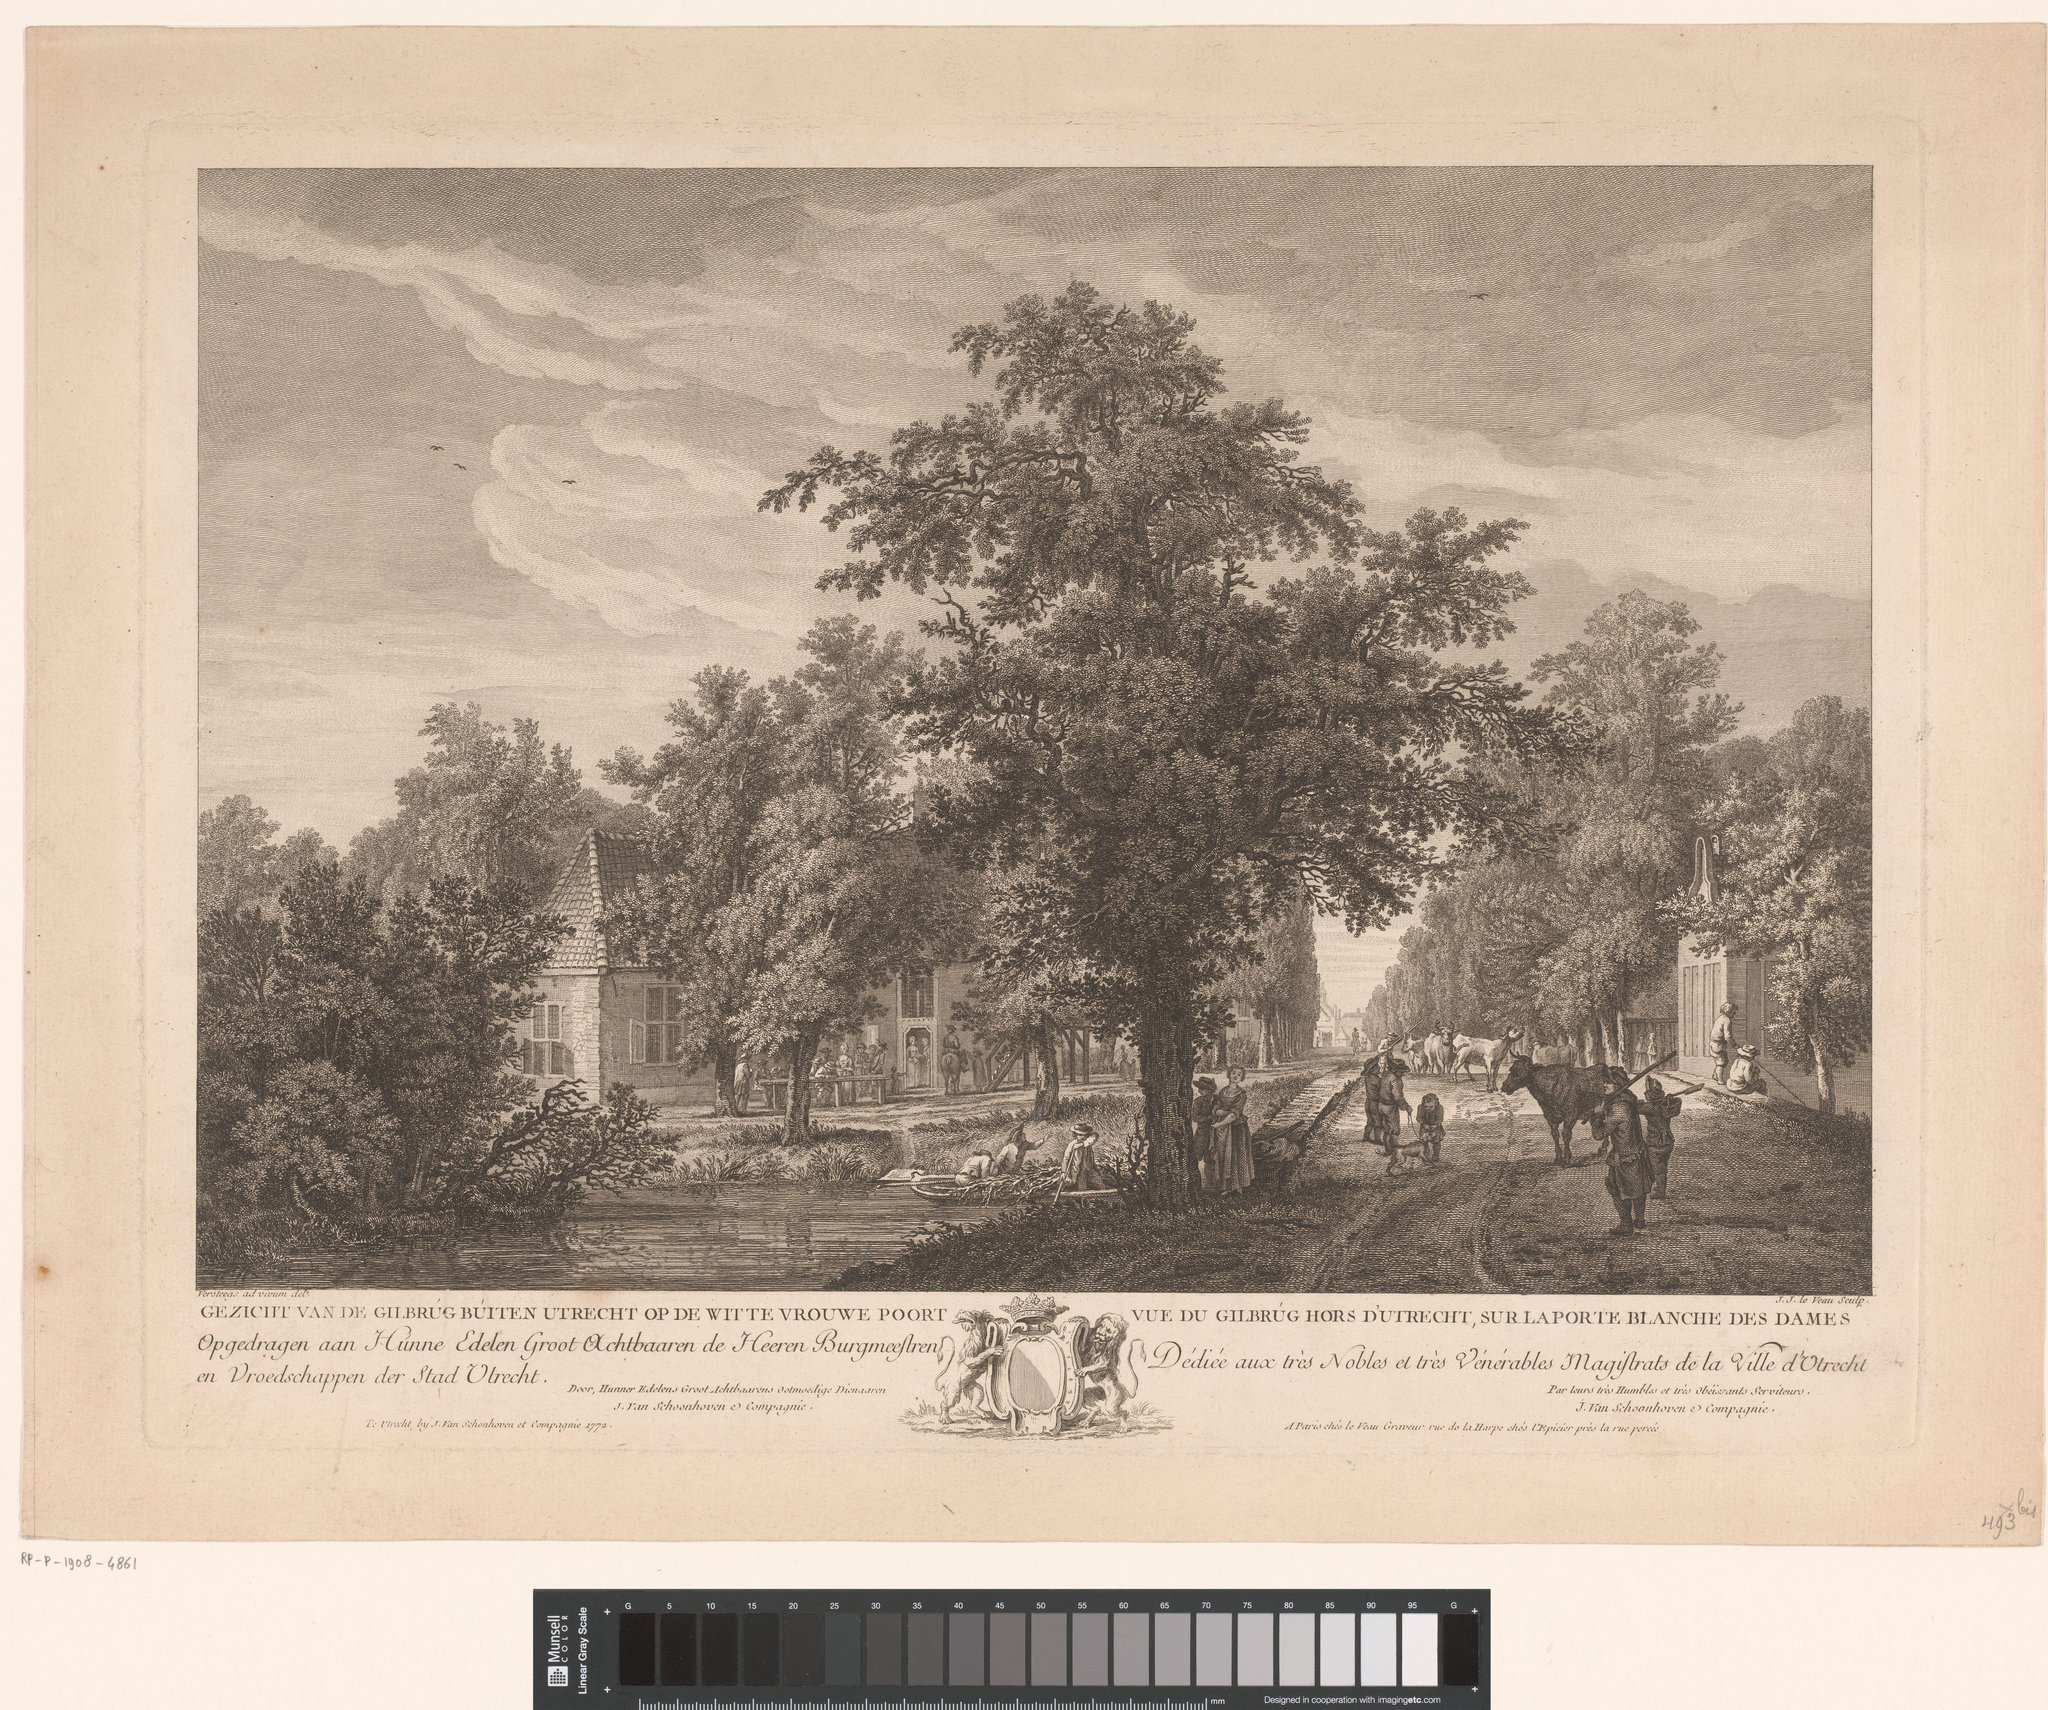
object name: print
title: Gezicht op de Wittevrouwenpoort bij Utrecht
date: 1772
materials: paper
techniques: engraving, etching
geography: paris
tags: bridge, city-gate, public road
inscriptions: dedication: ‘Opgedragen aan Hunne Edelen Groot Achtbaaren de Heeren Burgmeestren/ en Vroedschappen der Stad Utrecht.’, collector's mark: Lugt 2228, dedication: ‘Dédieé aux très Nobles et treès Vénérables Magistrats de la Ville d'Utrecht’